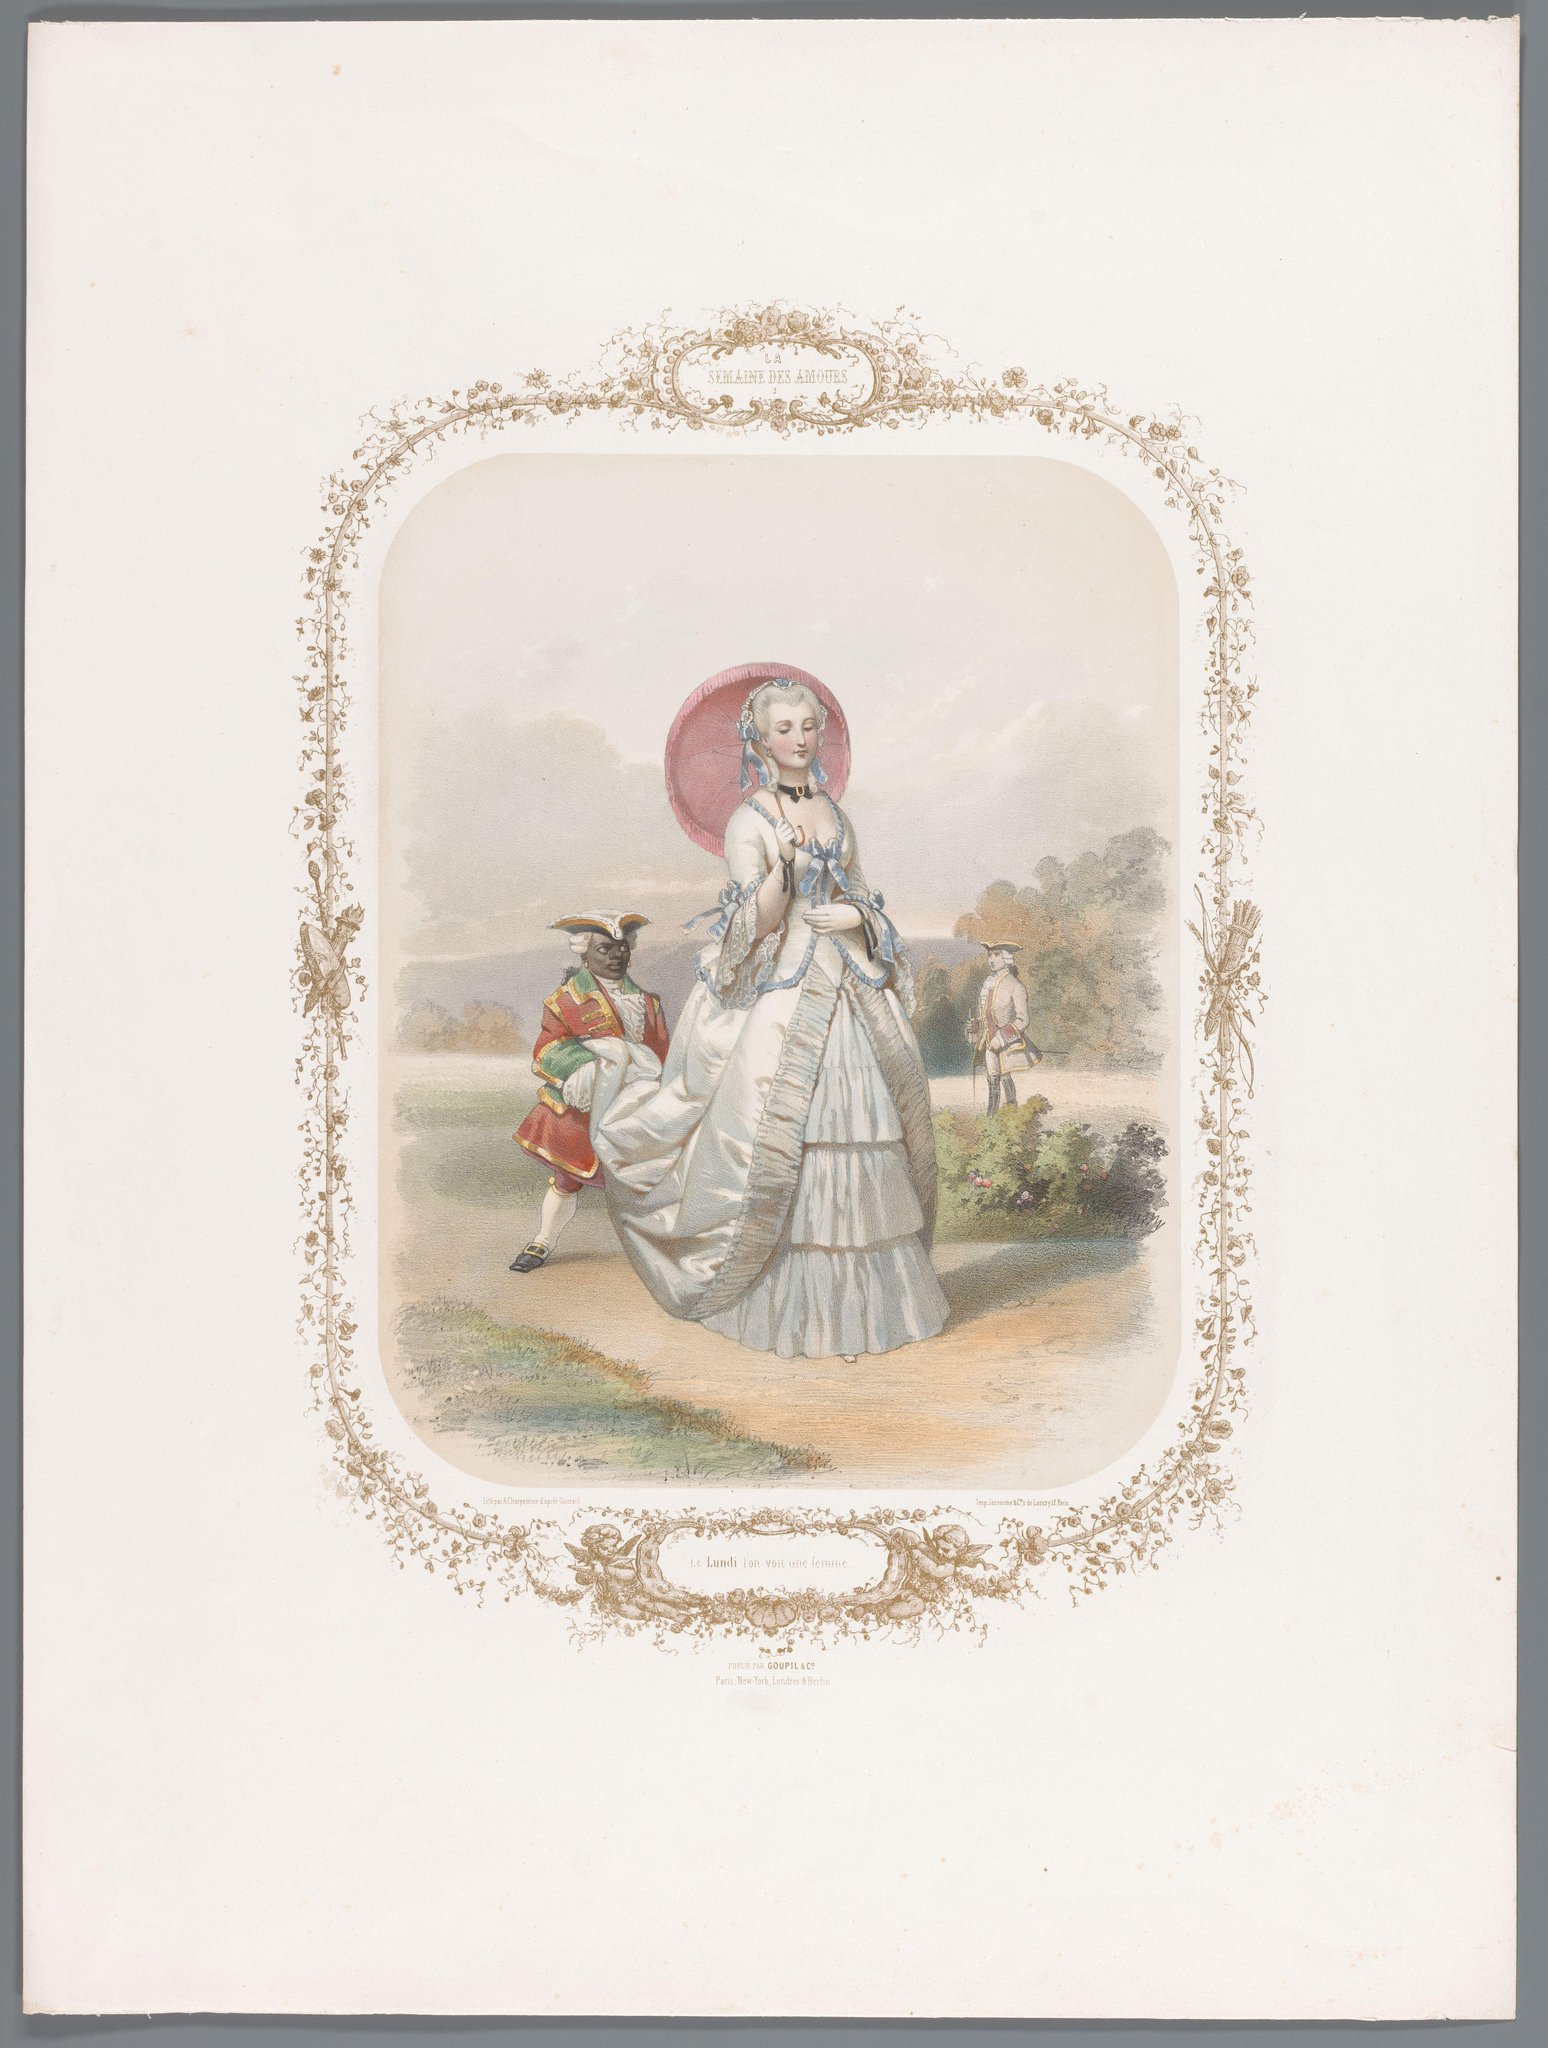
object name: print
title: Week van de liefde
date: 1852-1857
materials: paper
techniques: hand coloring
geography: paris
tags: awakening love, amorousness, desire, fashionable woman, 'belle'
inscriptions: collector's mark: Lugt 2233, check stamp: Lugt 1090